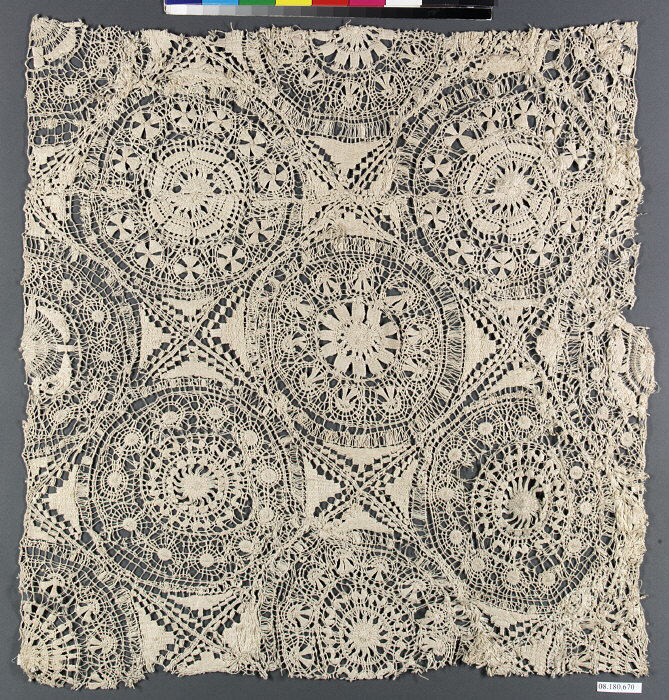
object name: fragment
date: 1501-1600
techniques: embroidery